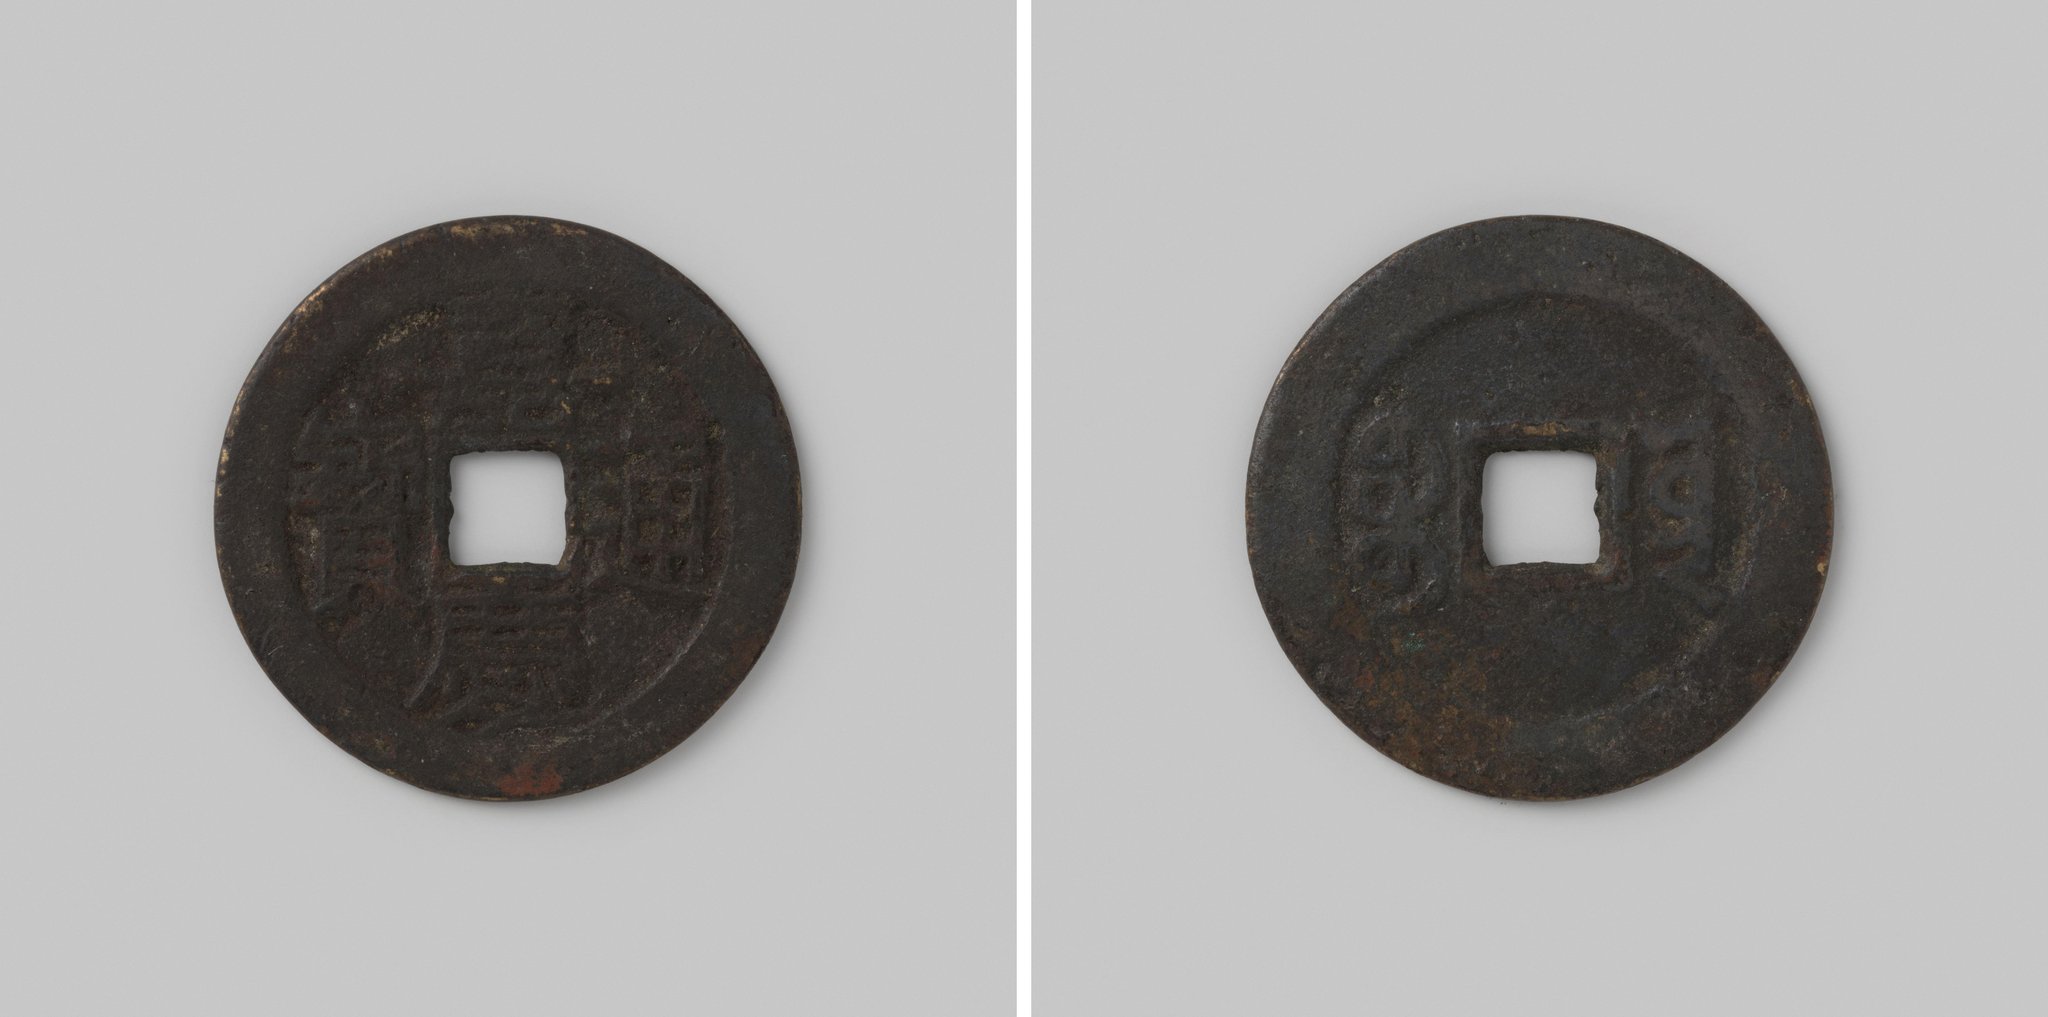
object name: coin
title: Cash van het keizerrijk China van de opstandeling Wu Shih Fan onder de regeringsnaam Hung-Hua, 1679 -1681, in Yunnan en Szechuan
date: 1679-1681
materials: copper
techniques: casting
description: Koperen munt. Voorzijde: binnen brede opstaande rand rondom vierkante uitsparing in het midden vier kruisgewijze geplaatste Chinese tekens, waarvan twee met de betekenis: Hung-Hua. Keerzijde: glad.